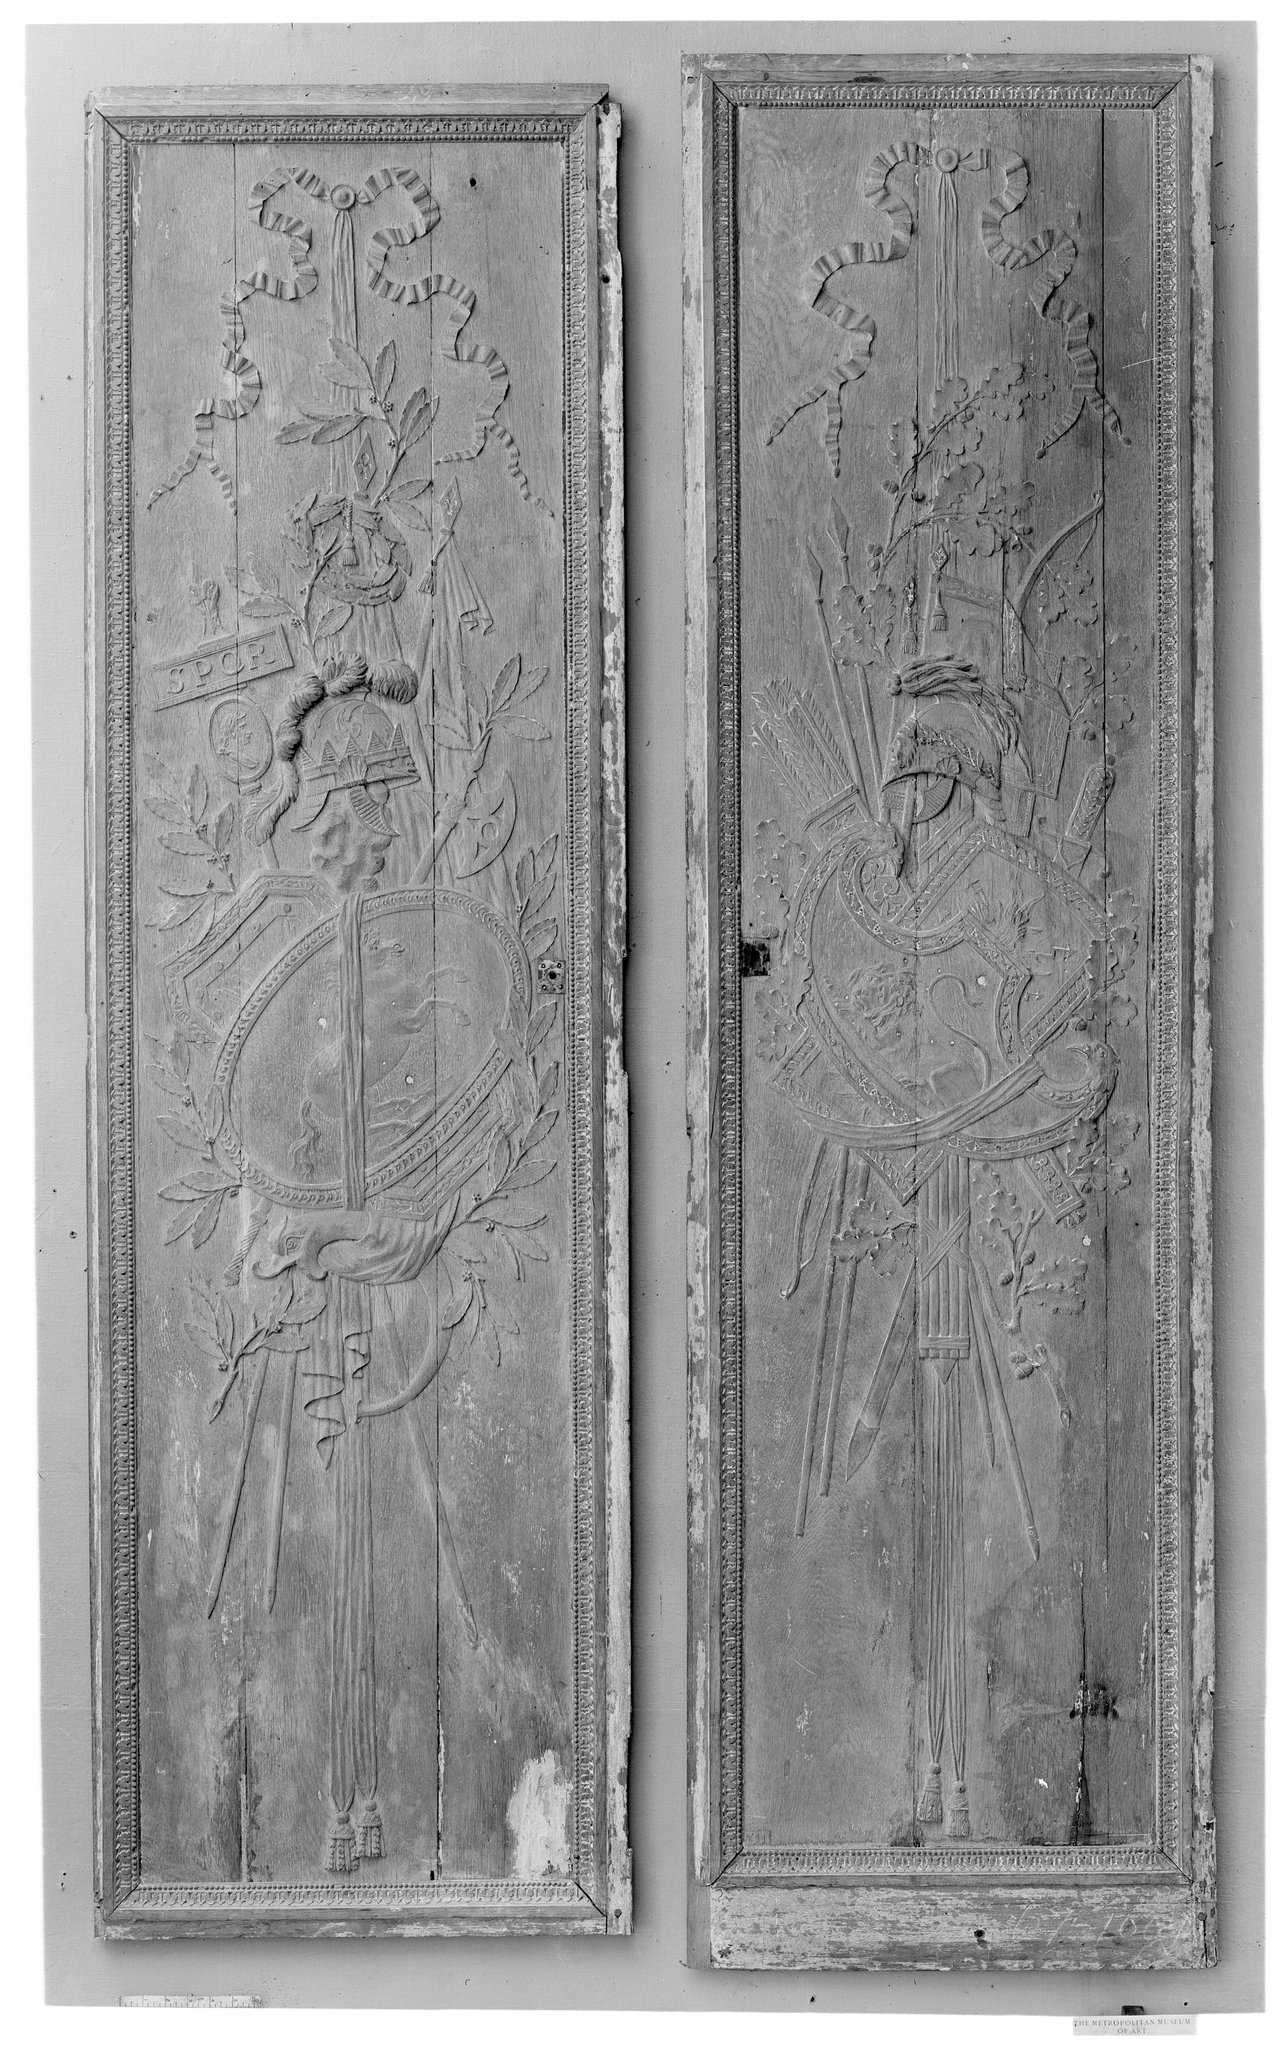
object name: door panel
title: Panel with trophy representing Africa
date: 1780-1785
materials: wood